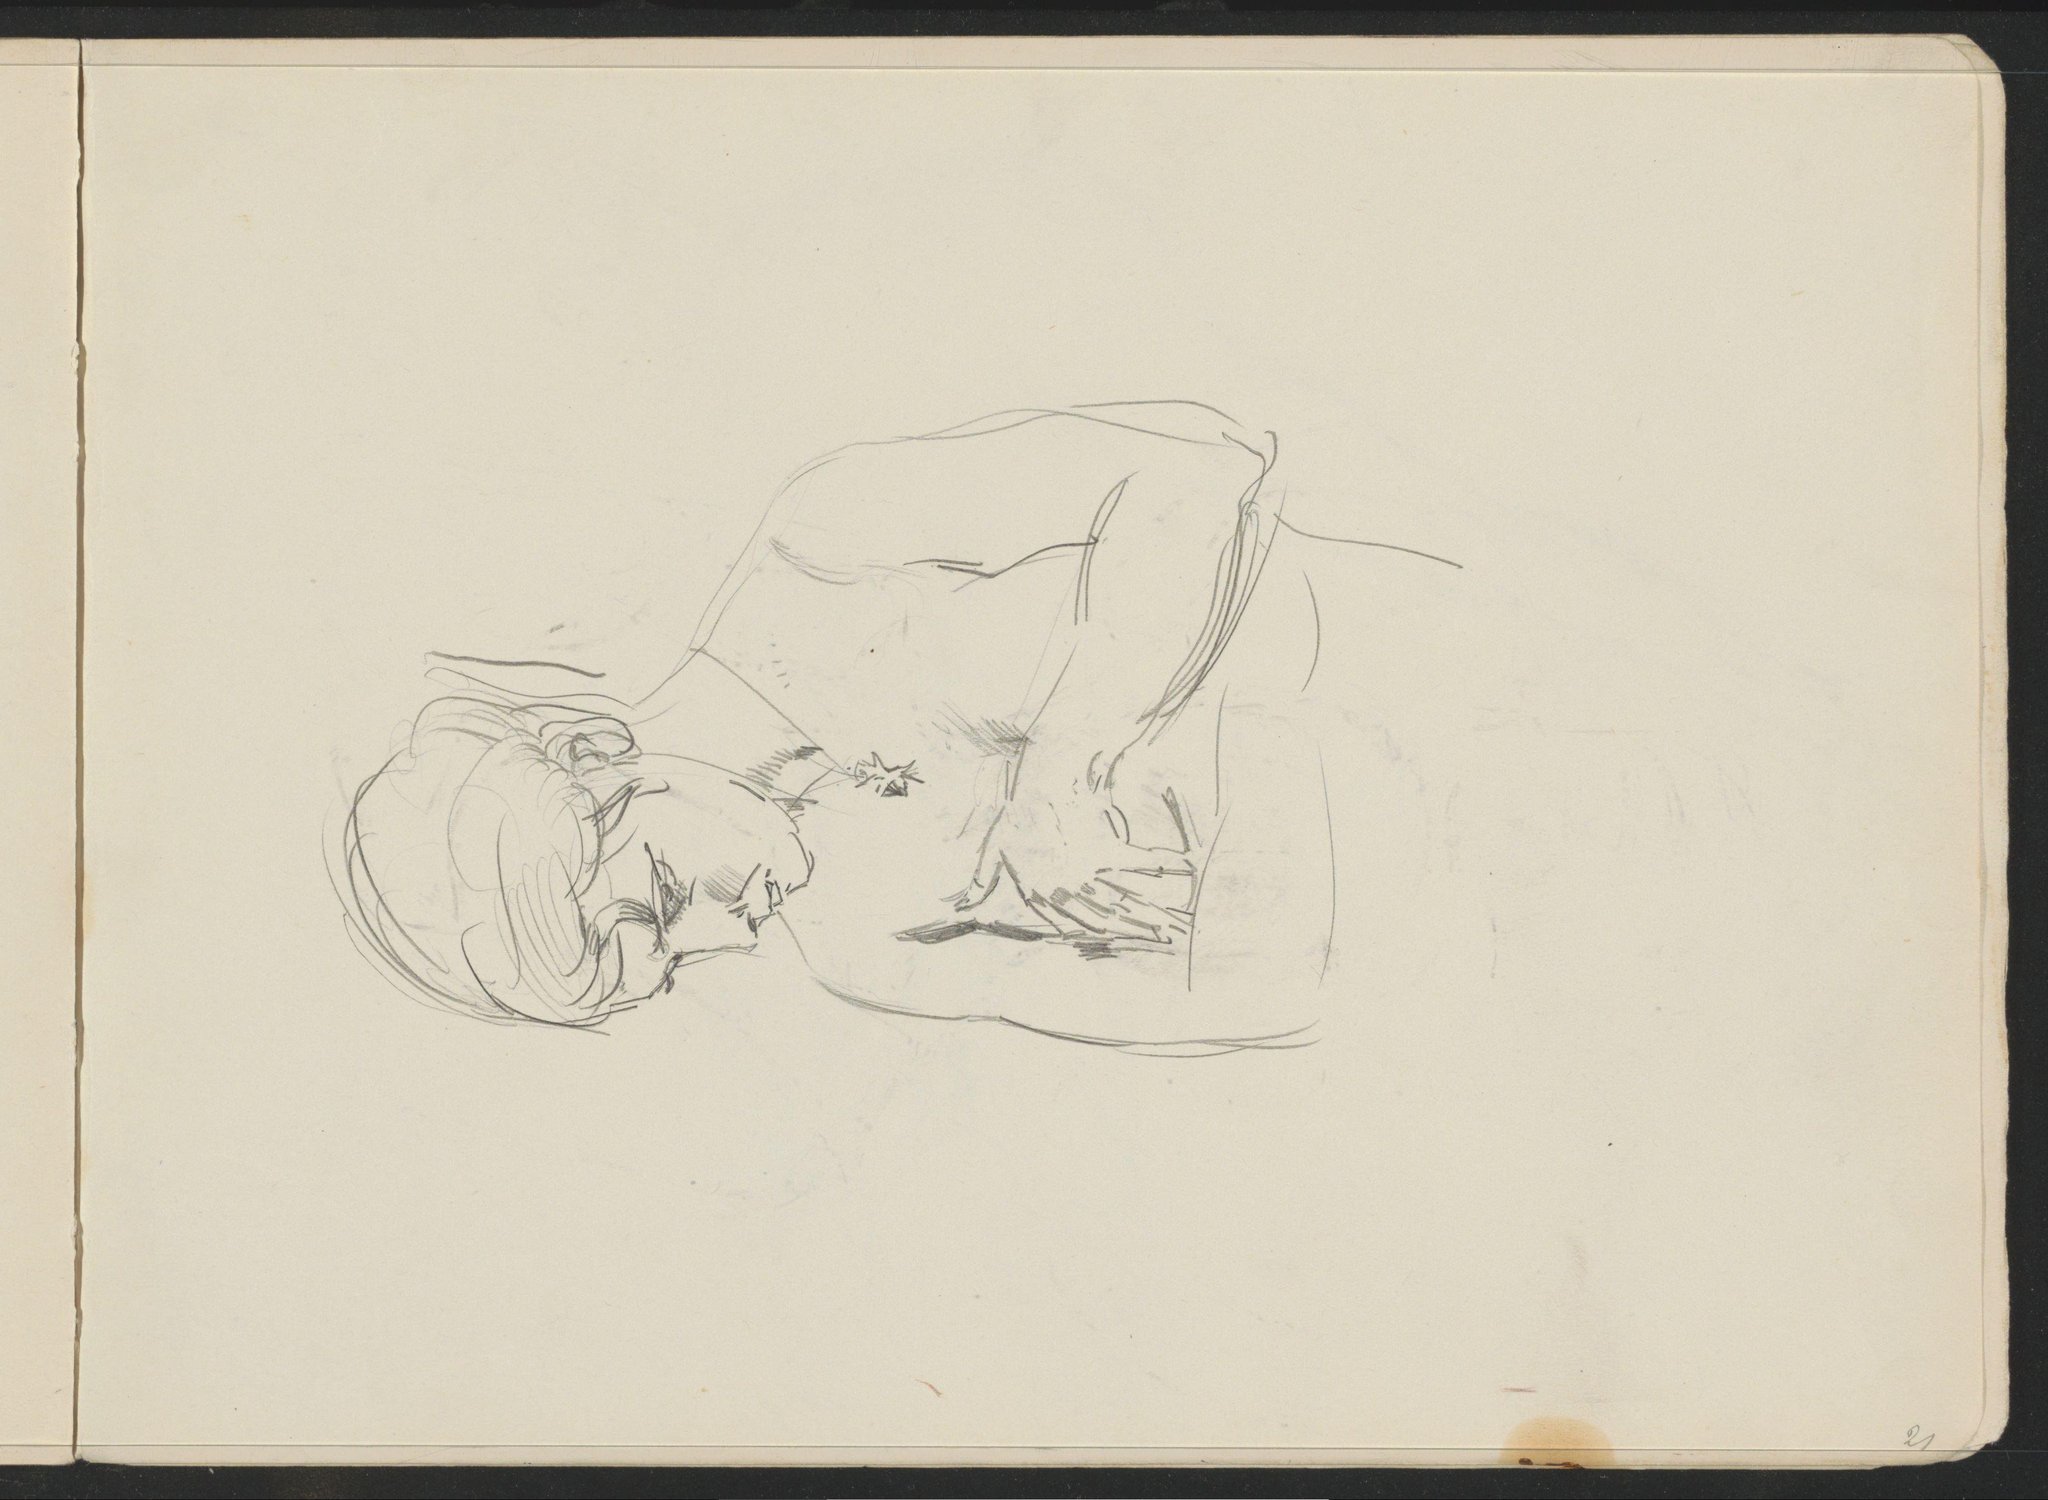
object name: sketchbook leaf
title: Vrouwelijk naakt met hanger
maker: isaac israels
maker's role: draughtsman, painter, print maker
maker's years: 1865-1934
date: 1915-1934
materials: paper, pencil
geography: the hague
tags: hand holding the breast, the (nude) human figure; 'corpo humano' (ripa) - aa - female human figure, necklace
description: Met haar rechterhand bedekt ze haar borst. Blad 21 recto uit schetsboek XV met 22 bladen.